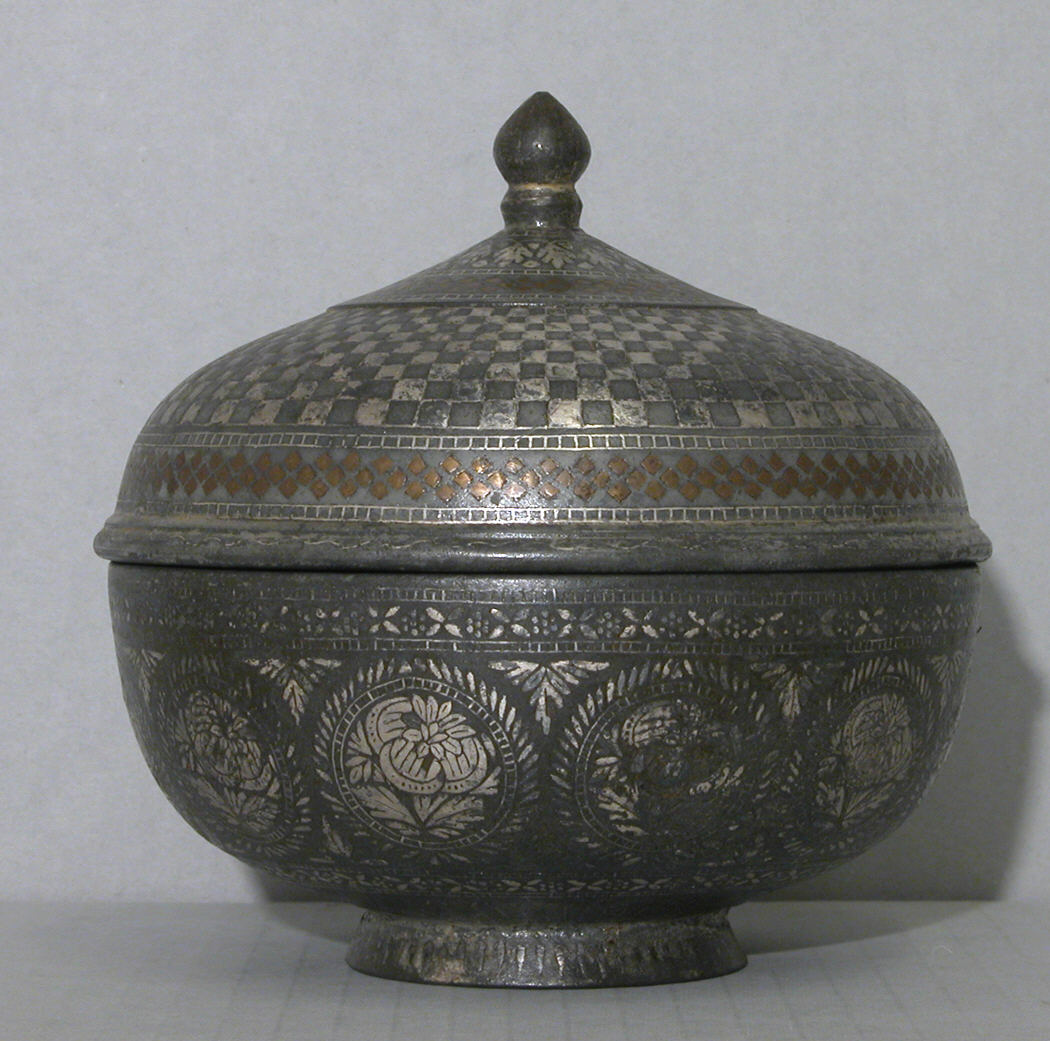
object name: bowl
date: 1801-1900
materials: alloy, brass, silver, zinc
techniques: casting, engraving, inlay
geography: india